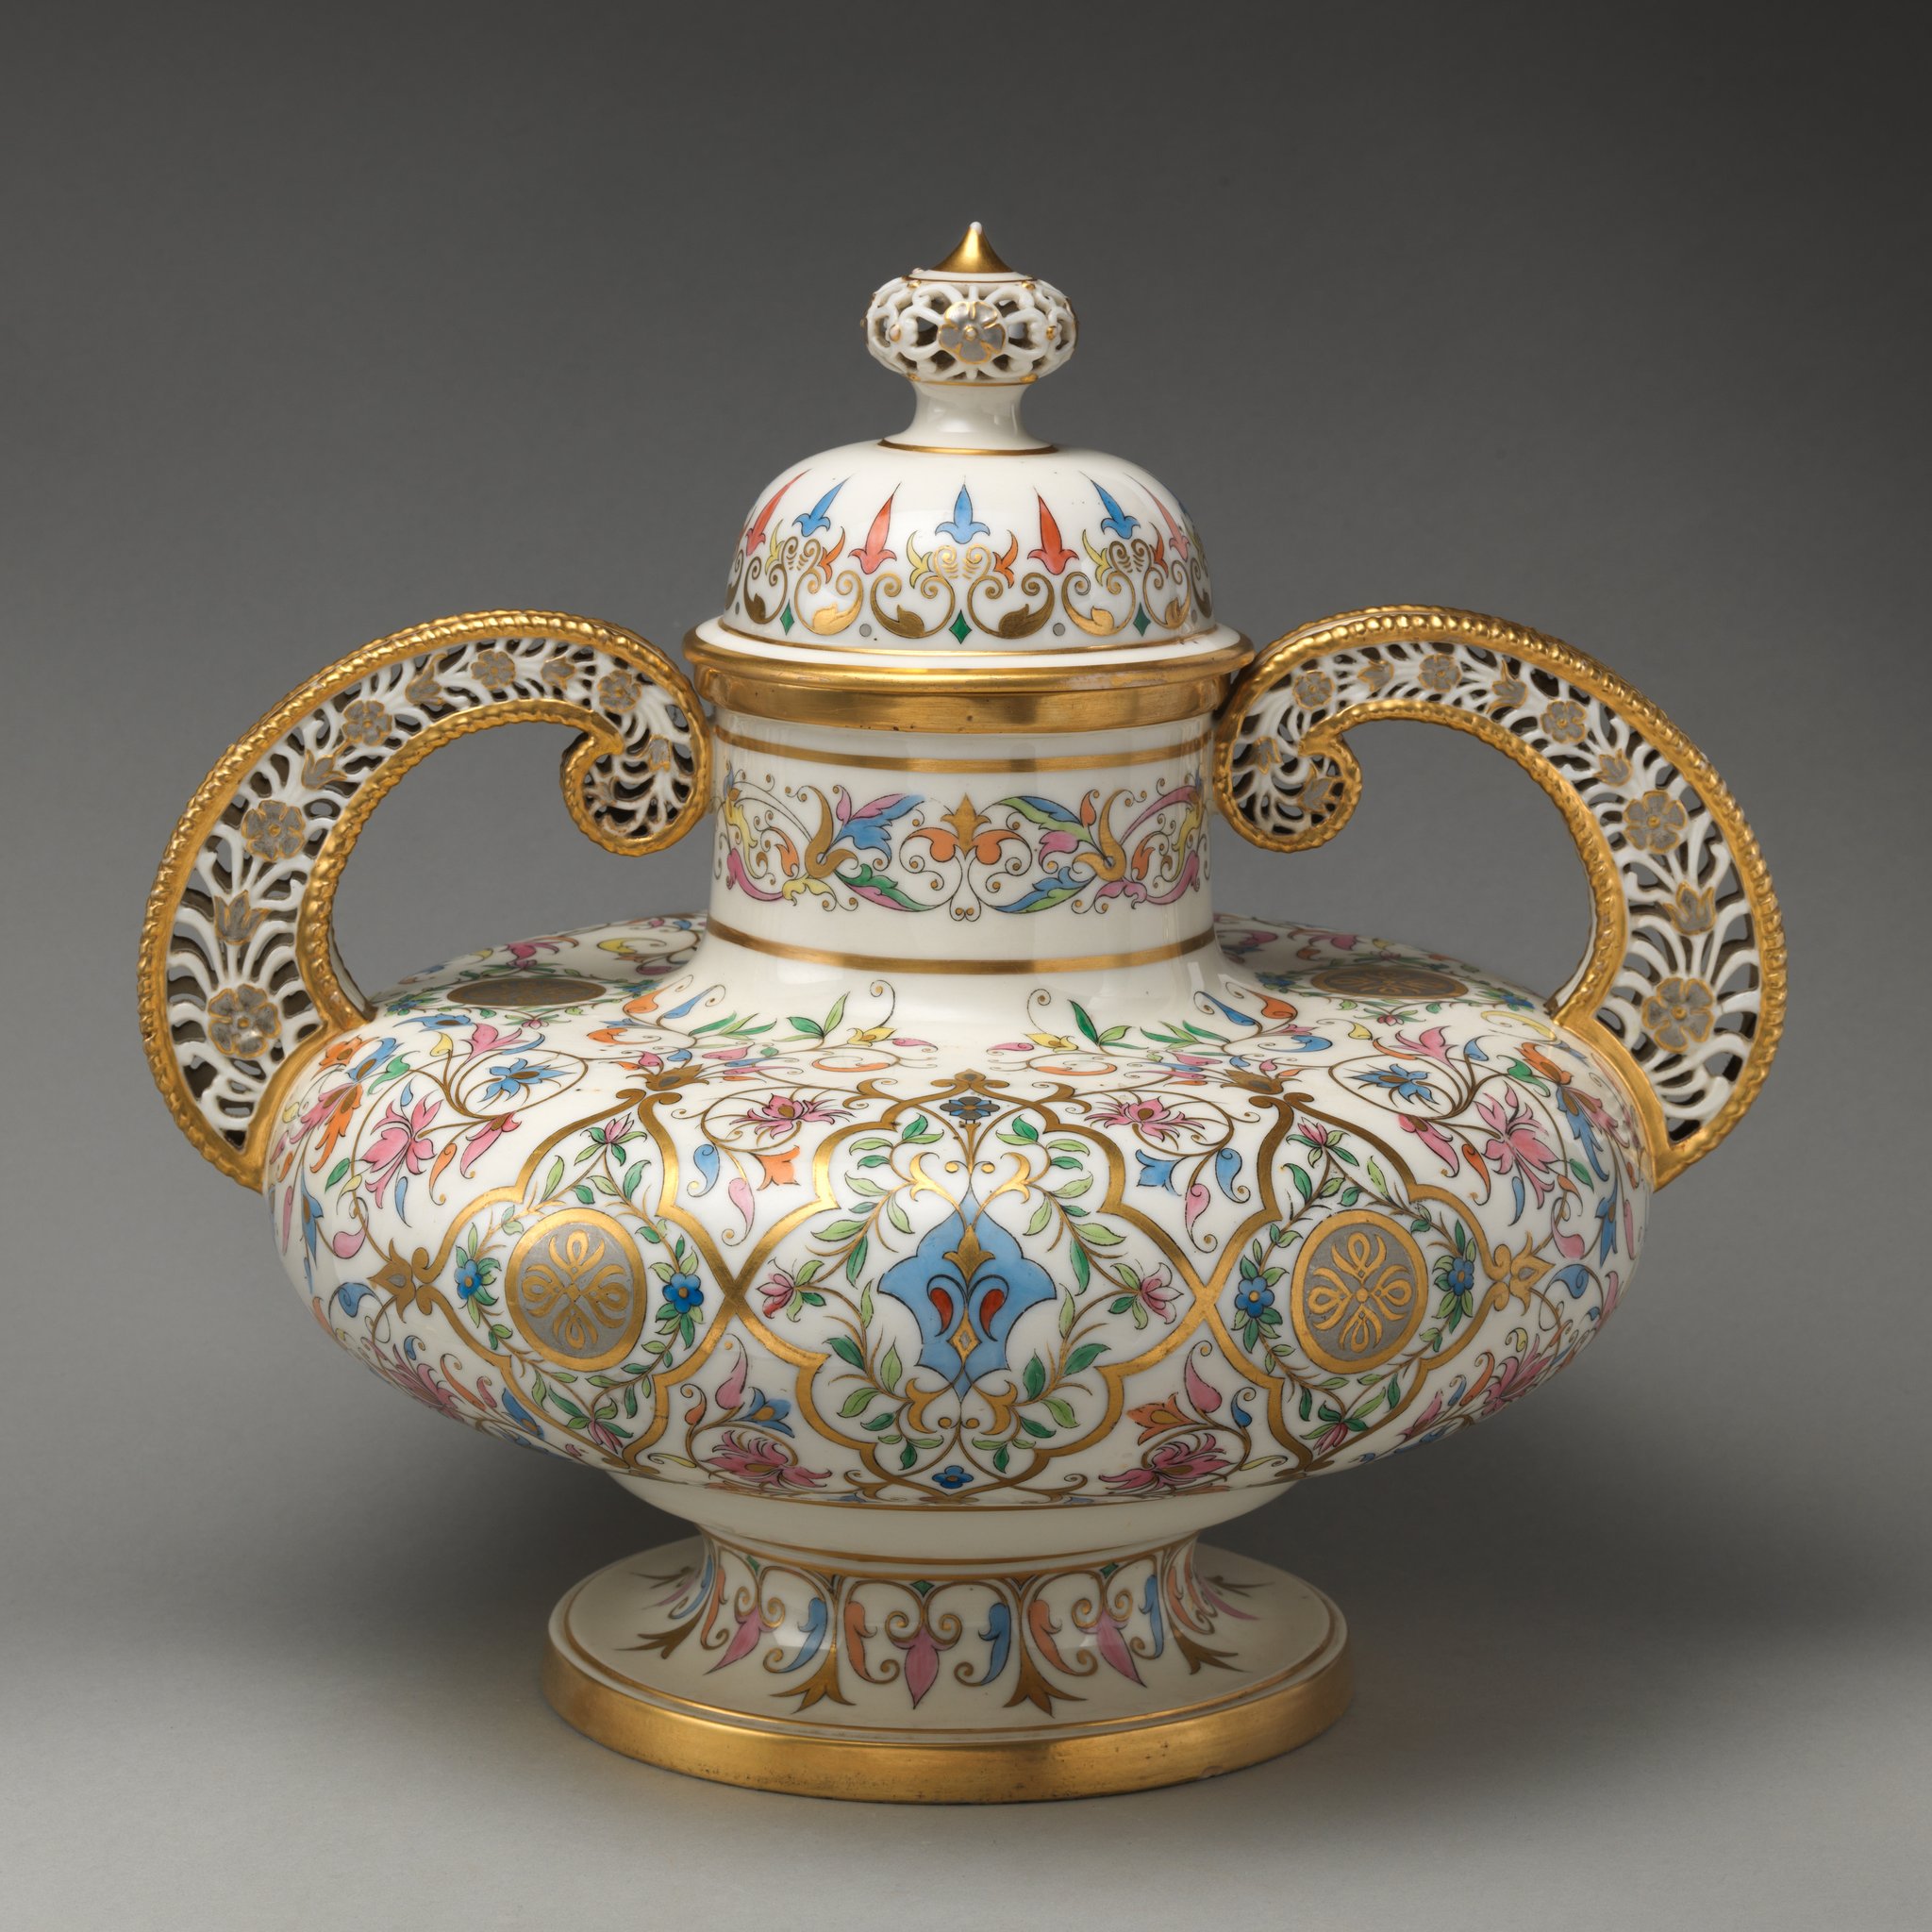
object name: lidded vase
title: "Alhambra" vase with lid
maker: crown derby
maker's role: maker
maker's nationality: british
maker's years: 1750-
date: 1880-1889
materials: enamel, porcelain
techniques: gilding